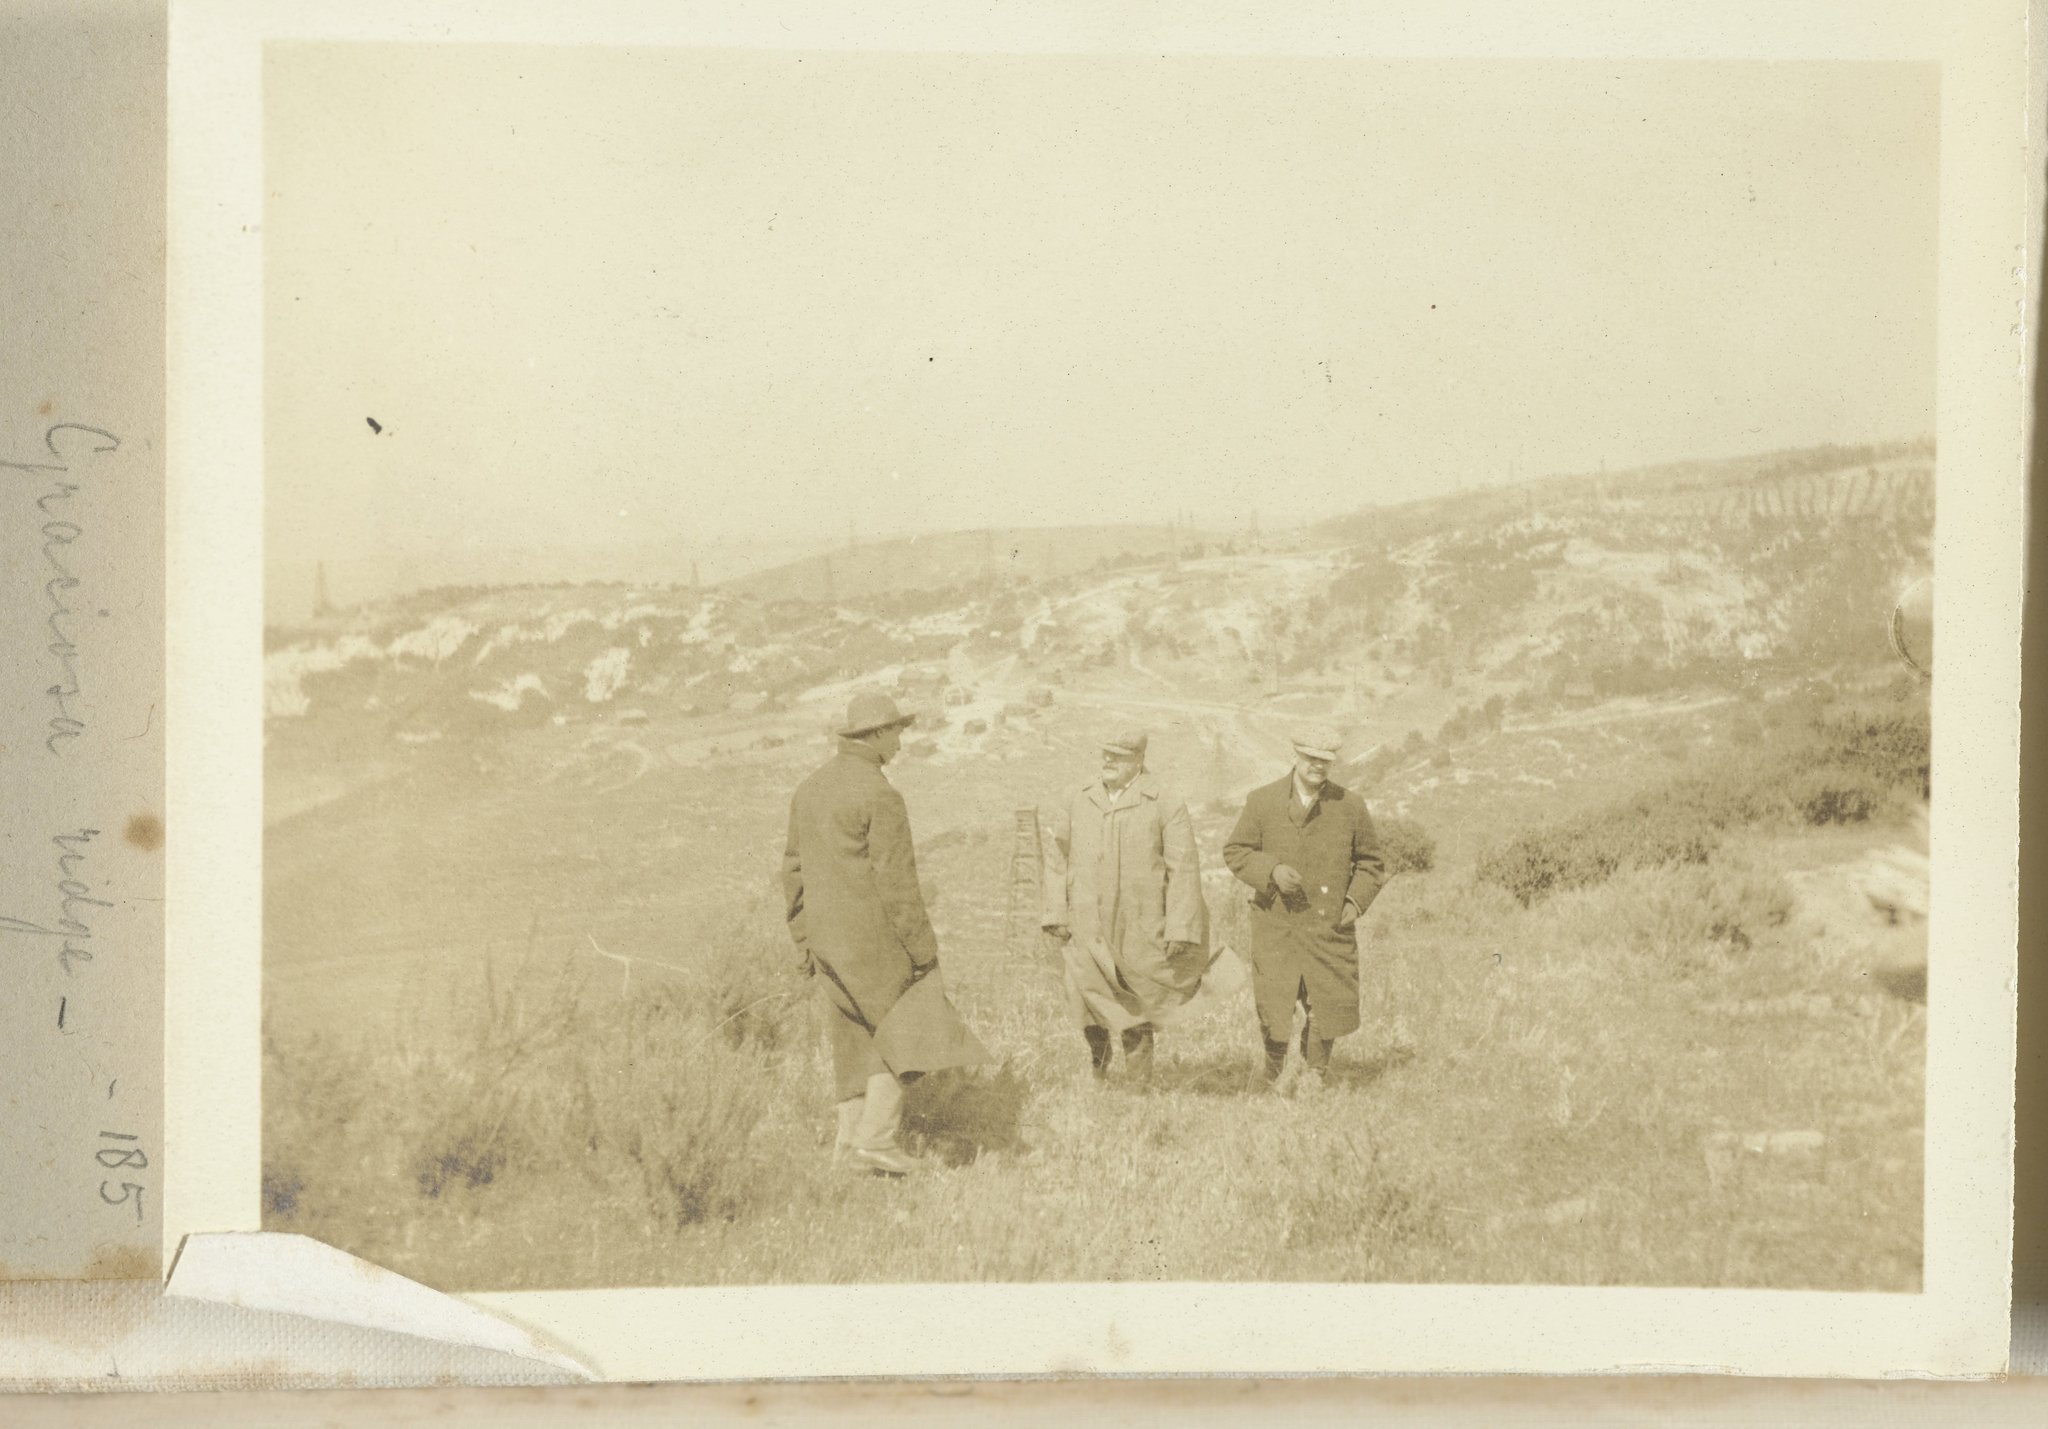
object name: photograph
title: Visit to an Oil Field in Purissima Hills, USA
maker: geldolph adriaan kessler (dolph)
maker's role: fotograaf, industrieel, voetballer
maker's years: 1884-1945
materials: cardboard, photographic support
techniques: gelatin silver print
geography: california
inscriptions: title: ‘Graciosa ridge’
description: In 1908 Kessler accompanied the director of Koninklijke Olie (Royal Dutch Petroleum Company, later Shell), Henri Deterding, as secretary on a world tour. He travelled to Canada and the United States via the Dutch East Indies, Singapore, China, and Japan. Dolph’s photo album contains pictures of an oil field in California, as well as San Francisco’s town hall which had collapsed during an earthquake.